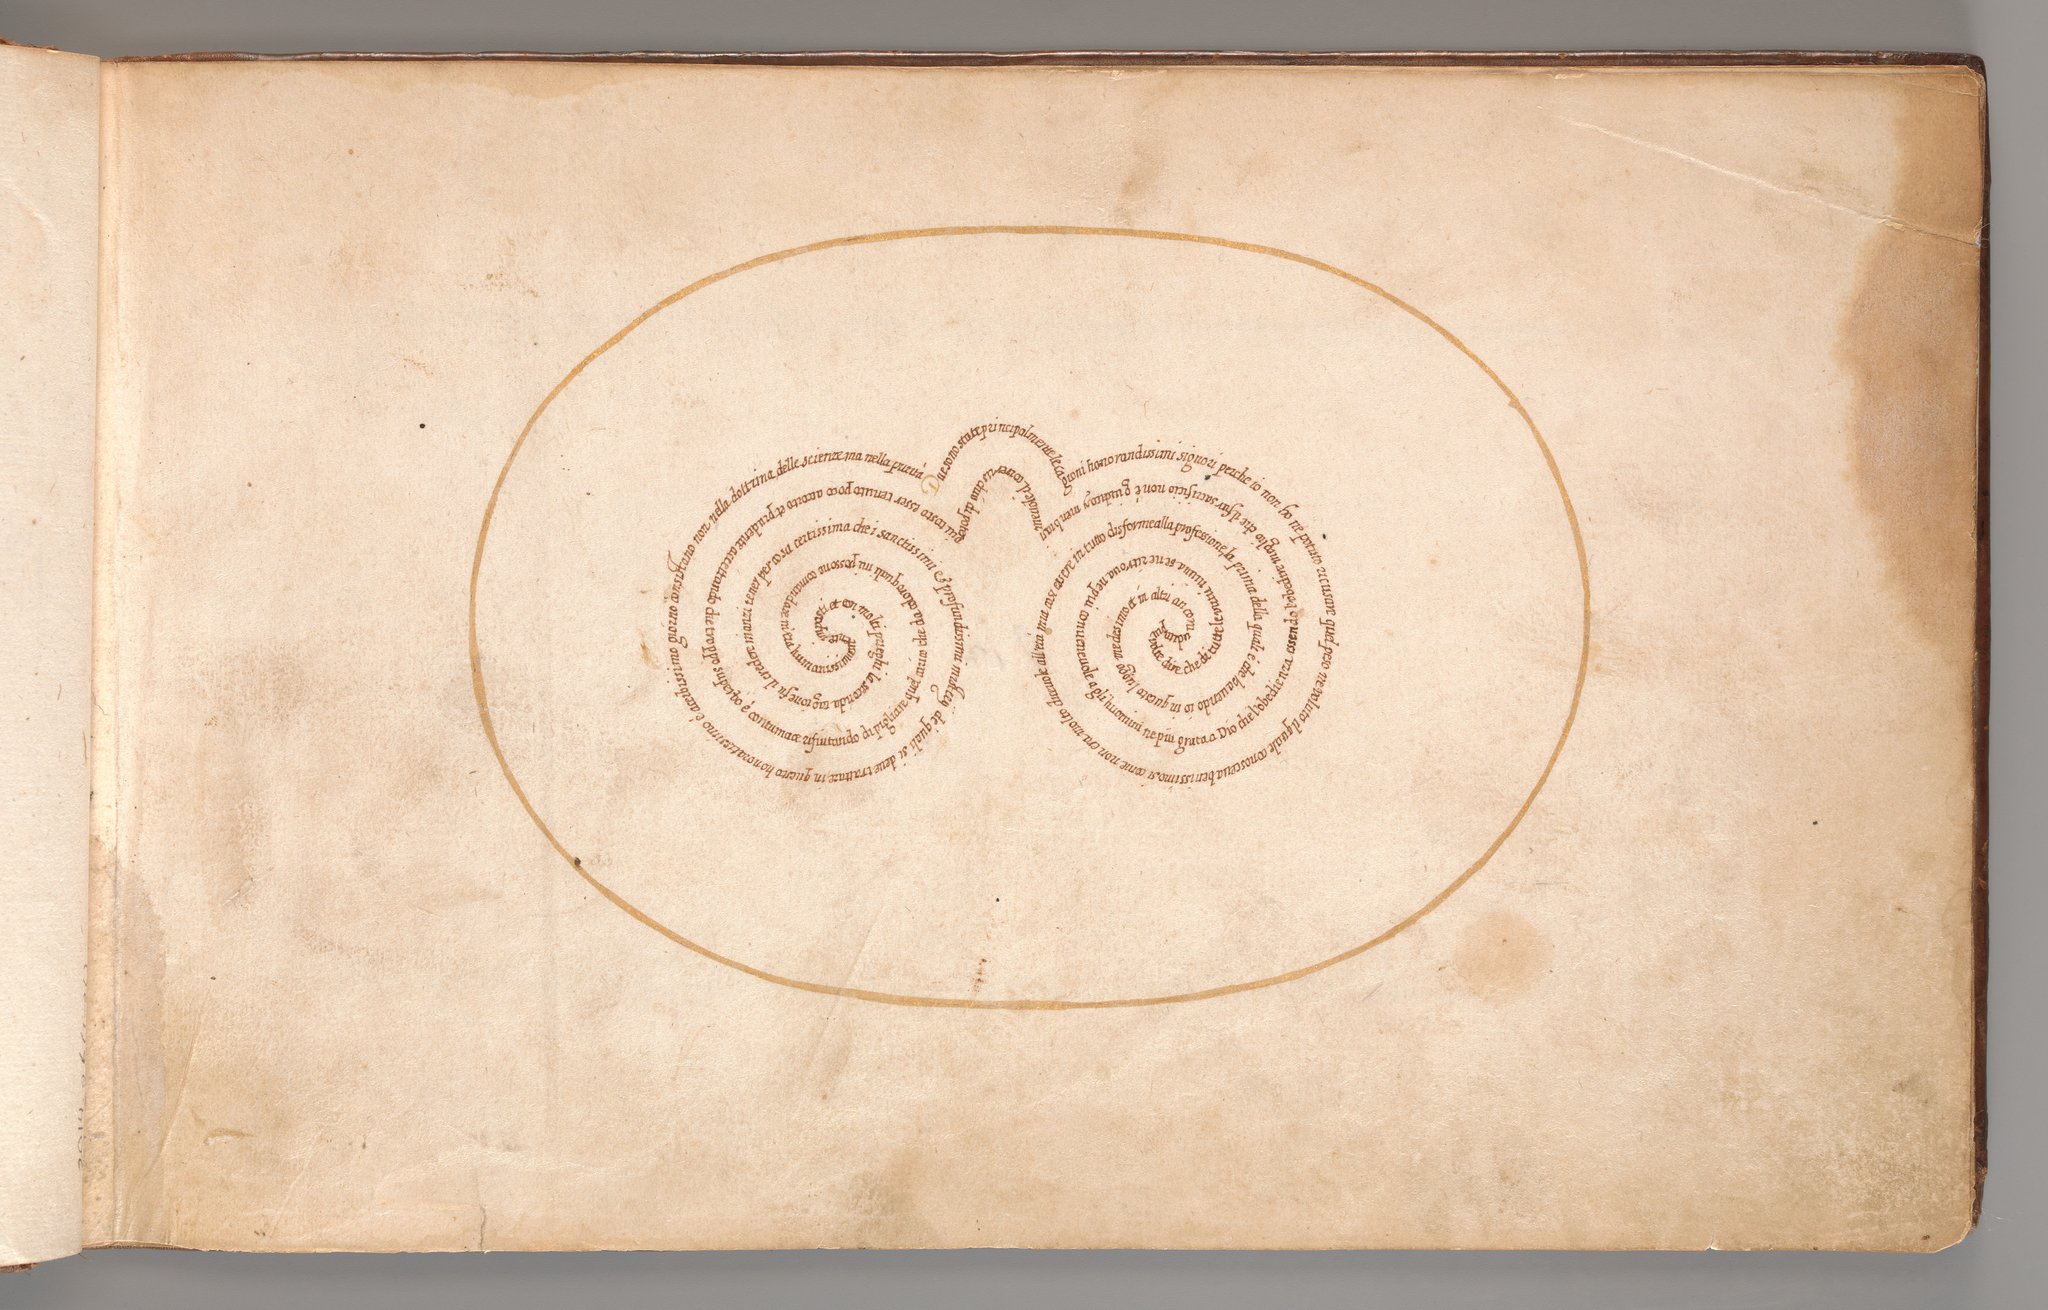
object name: album print ornament architecture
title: Micrographic Design in the Shape of a Pair of Glasses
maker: Anonymous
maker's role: artist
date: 1601-1633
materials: ink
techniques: pen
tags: abstraction